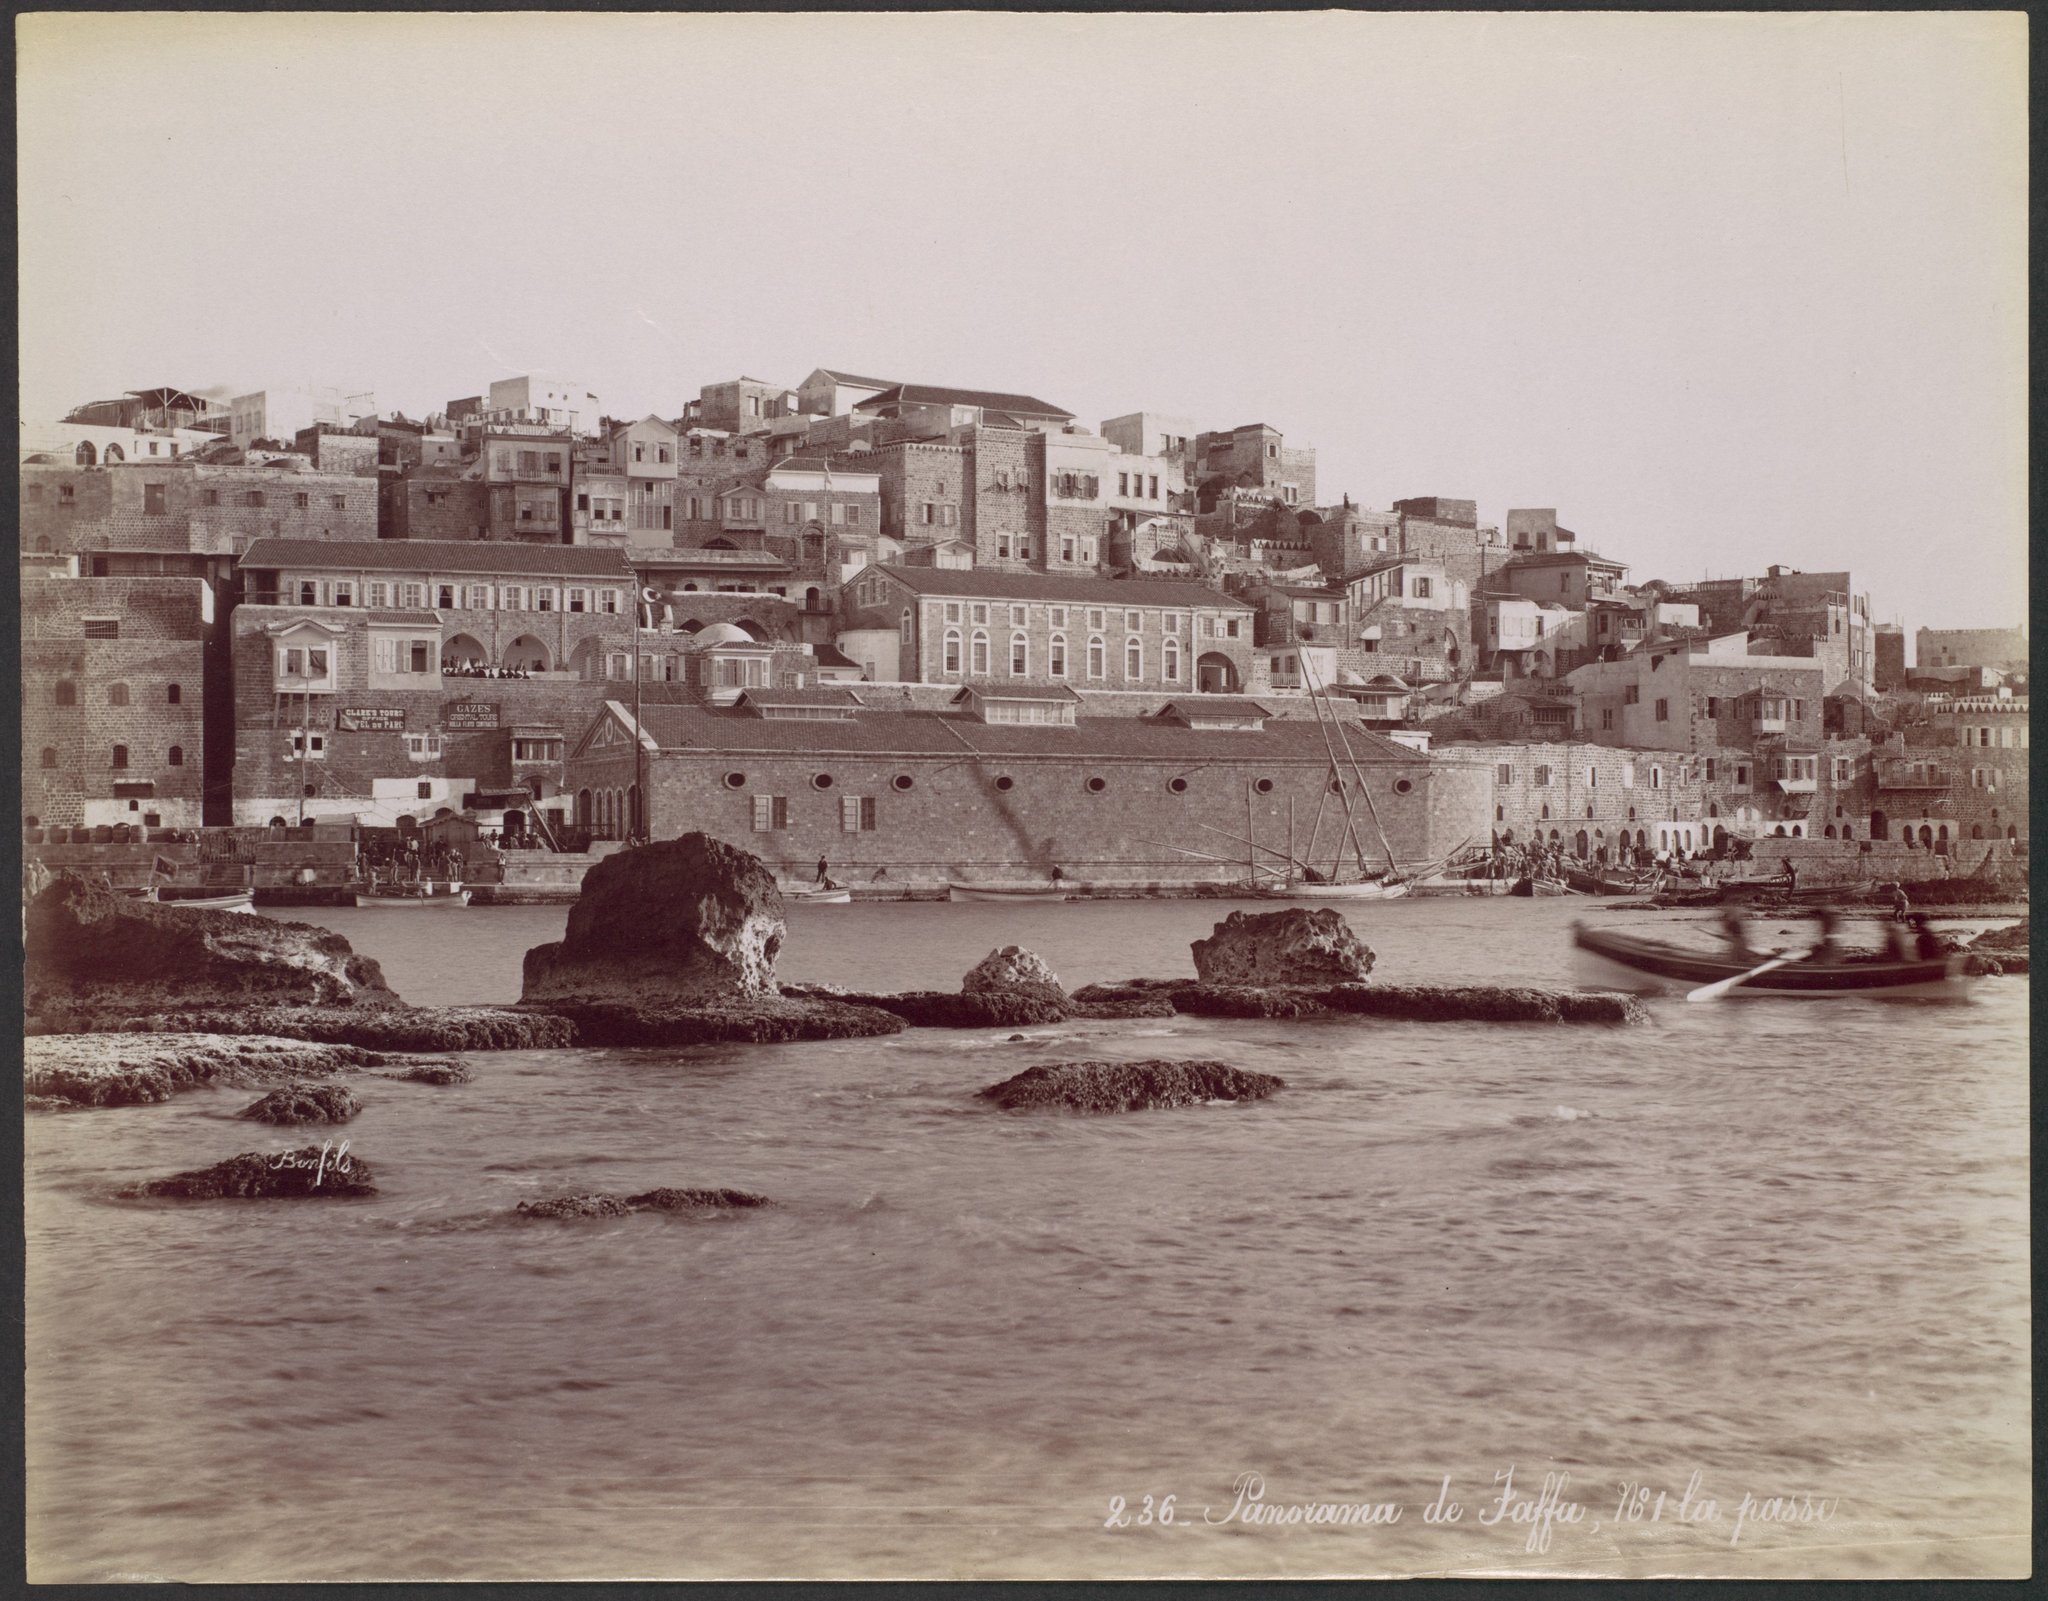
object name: photograph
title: Panorama de Jaffa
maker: félix bonfils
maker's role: fotograaf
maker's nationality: french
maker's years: 1831-1885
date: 1880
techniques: albumen silver print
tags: buildings,cities